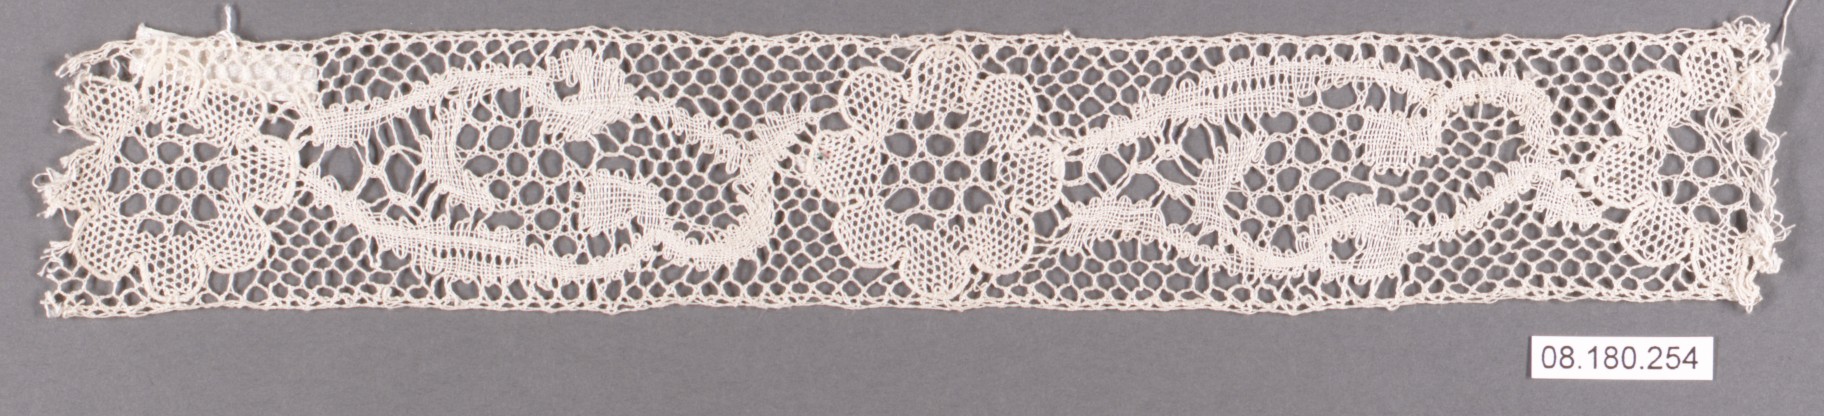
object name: insertion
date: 1801-1900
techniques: lace